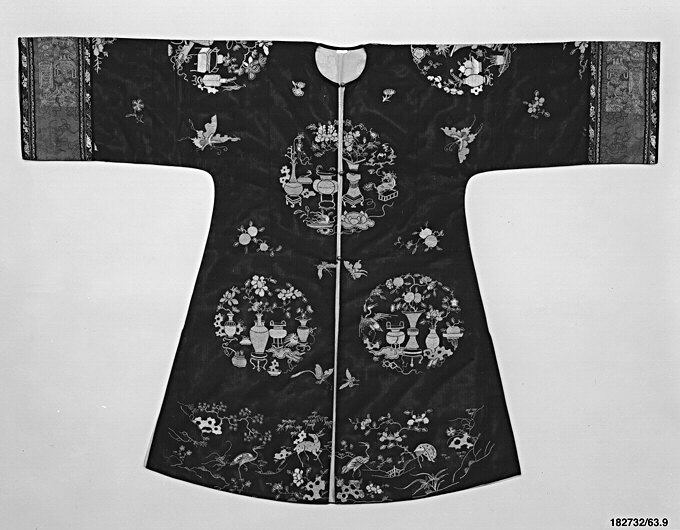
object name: woman's informal jacket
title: Woman's Informal Jacket with Antiquities in Medallions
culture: chinese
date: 1801-1900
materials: textile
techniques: embroidery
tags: birds,insects